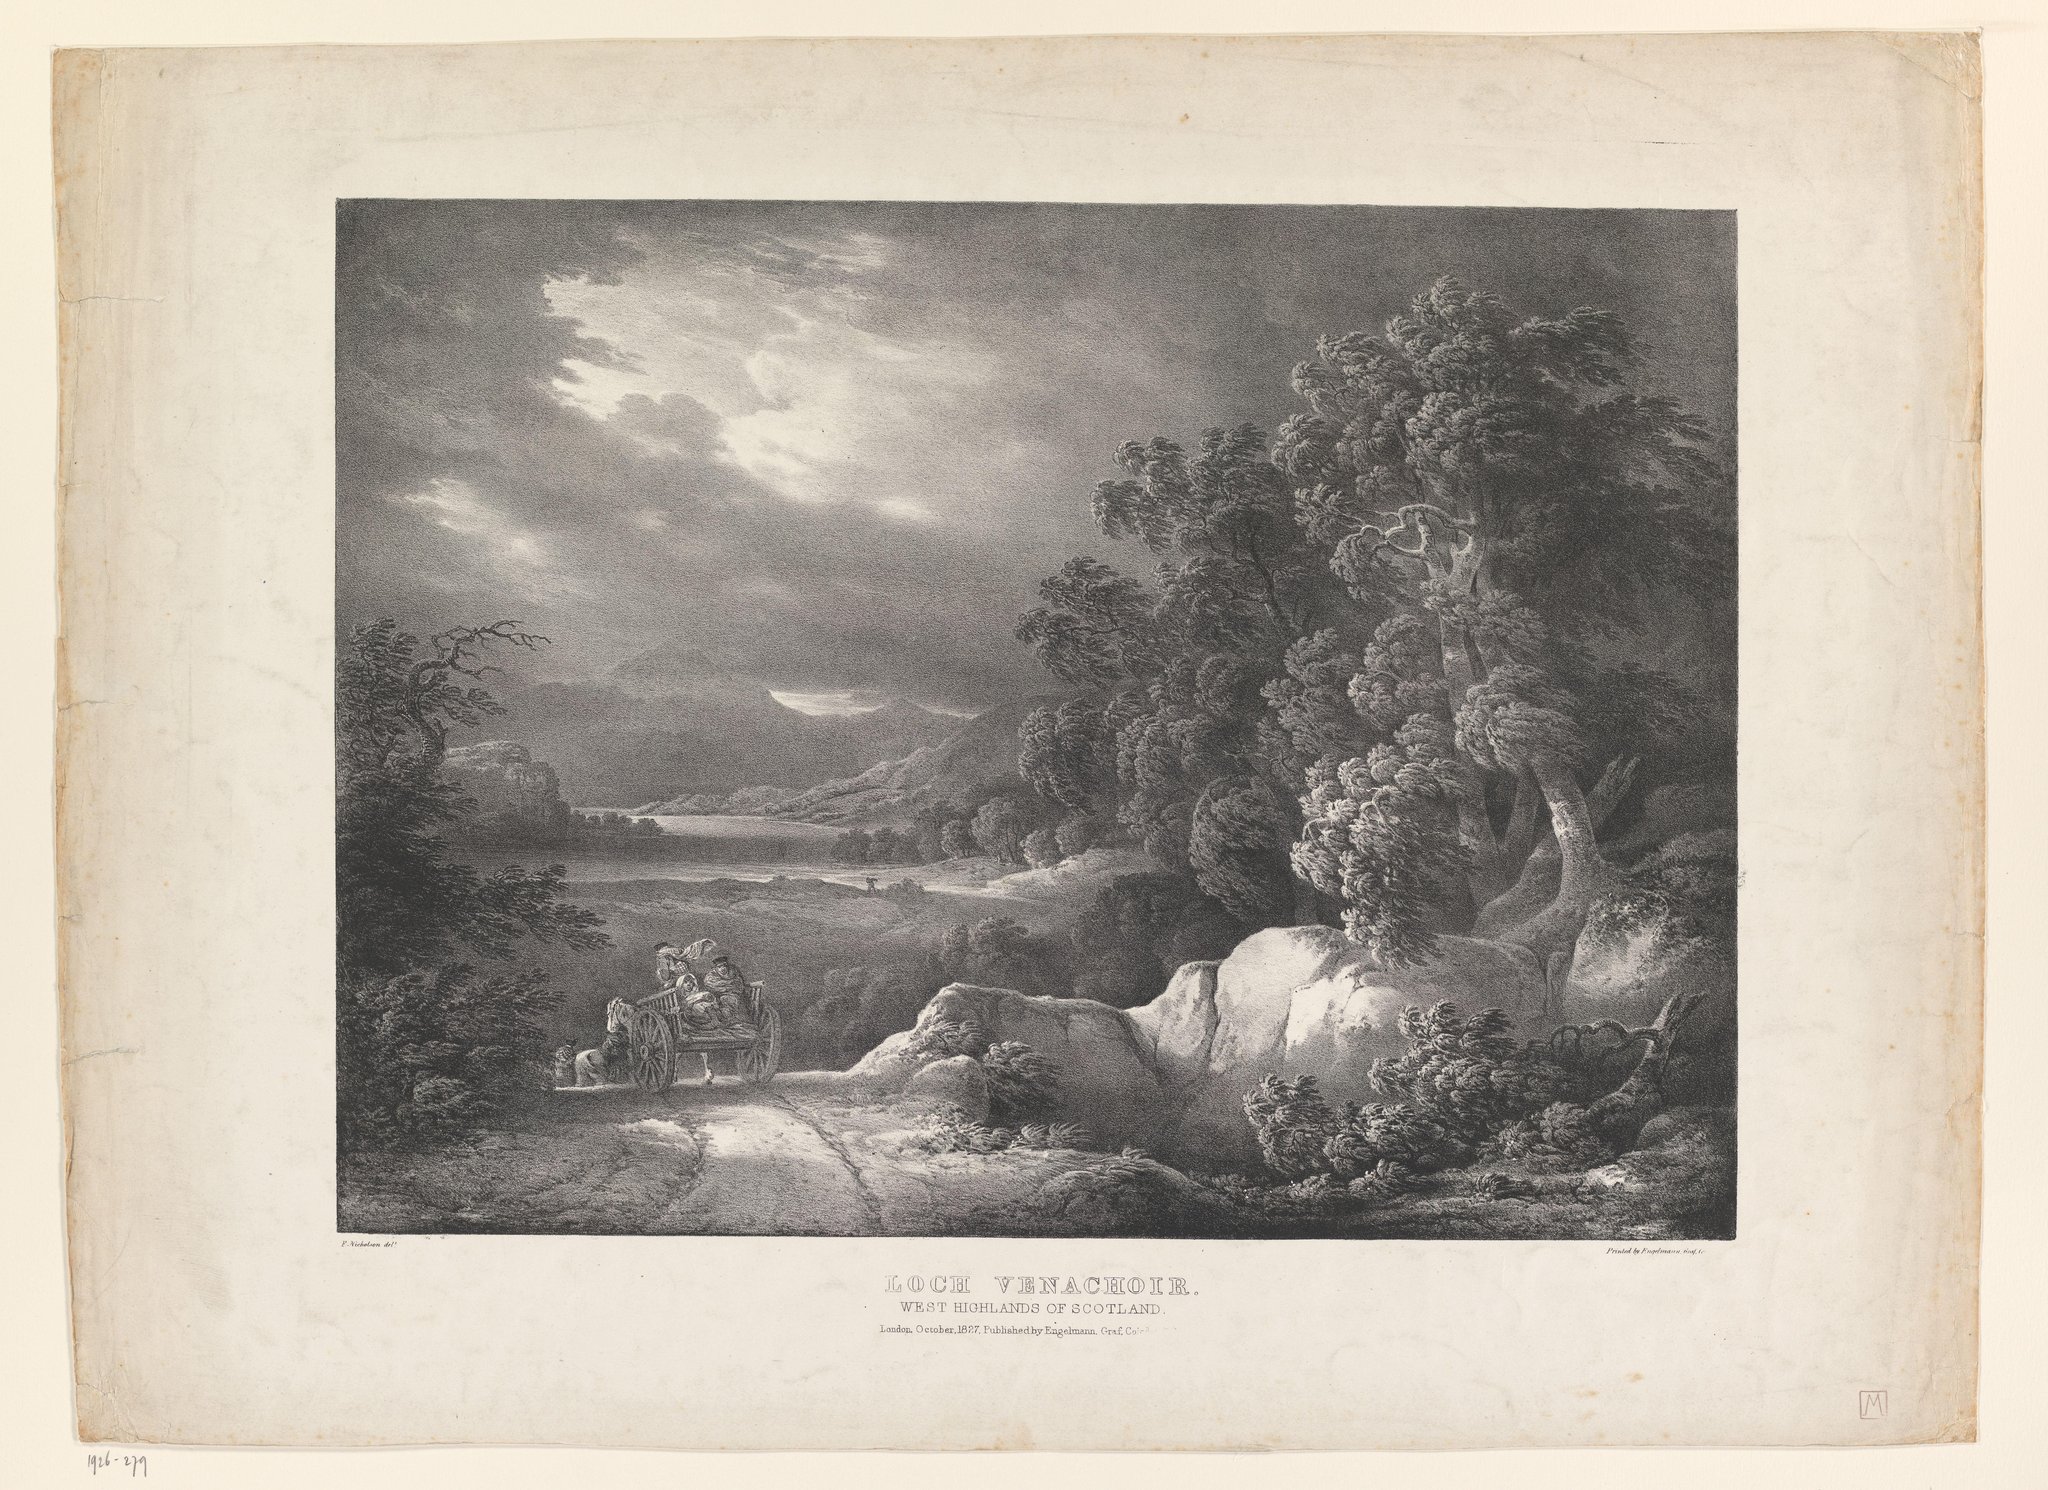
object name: print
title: Gezicht op Loch Venachar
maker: francis nicholson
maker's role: print maker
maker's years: 1753-1844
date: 1827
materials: paper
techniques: lithograph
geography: london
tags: two-wheeled vehicle drawn by one animal, lake (+ landscape with figures, staffage)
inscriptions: mark: Lugt 1849a, collector's mark: Lugt 2228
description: Loch Venachoir: gezicht op het meer, omgeven door bomen op de voorgrond en heuvels op de achtergrond. Op de landweg een kar waarop drie figuren. Landschap bij stormachtig weer.